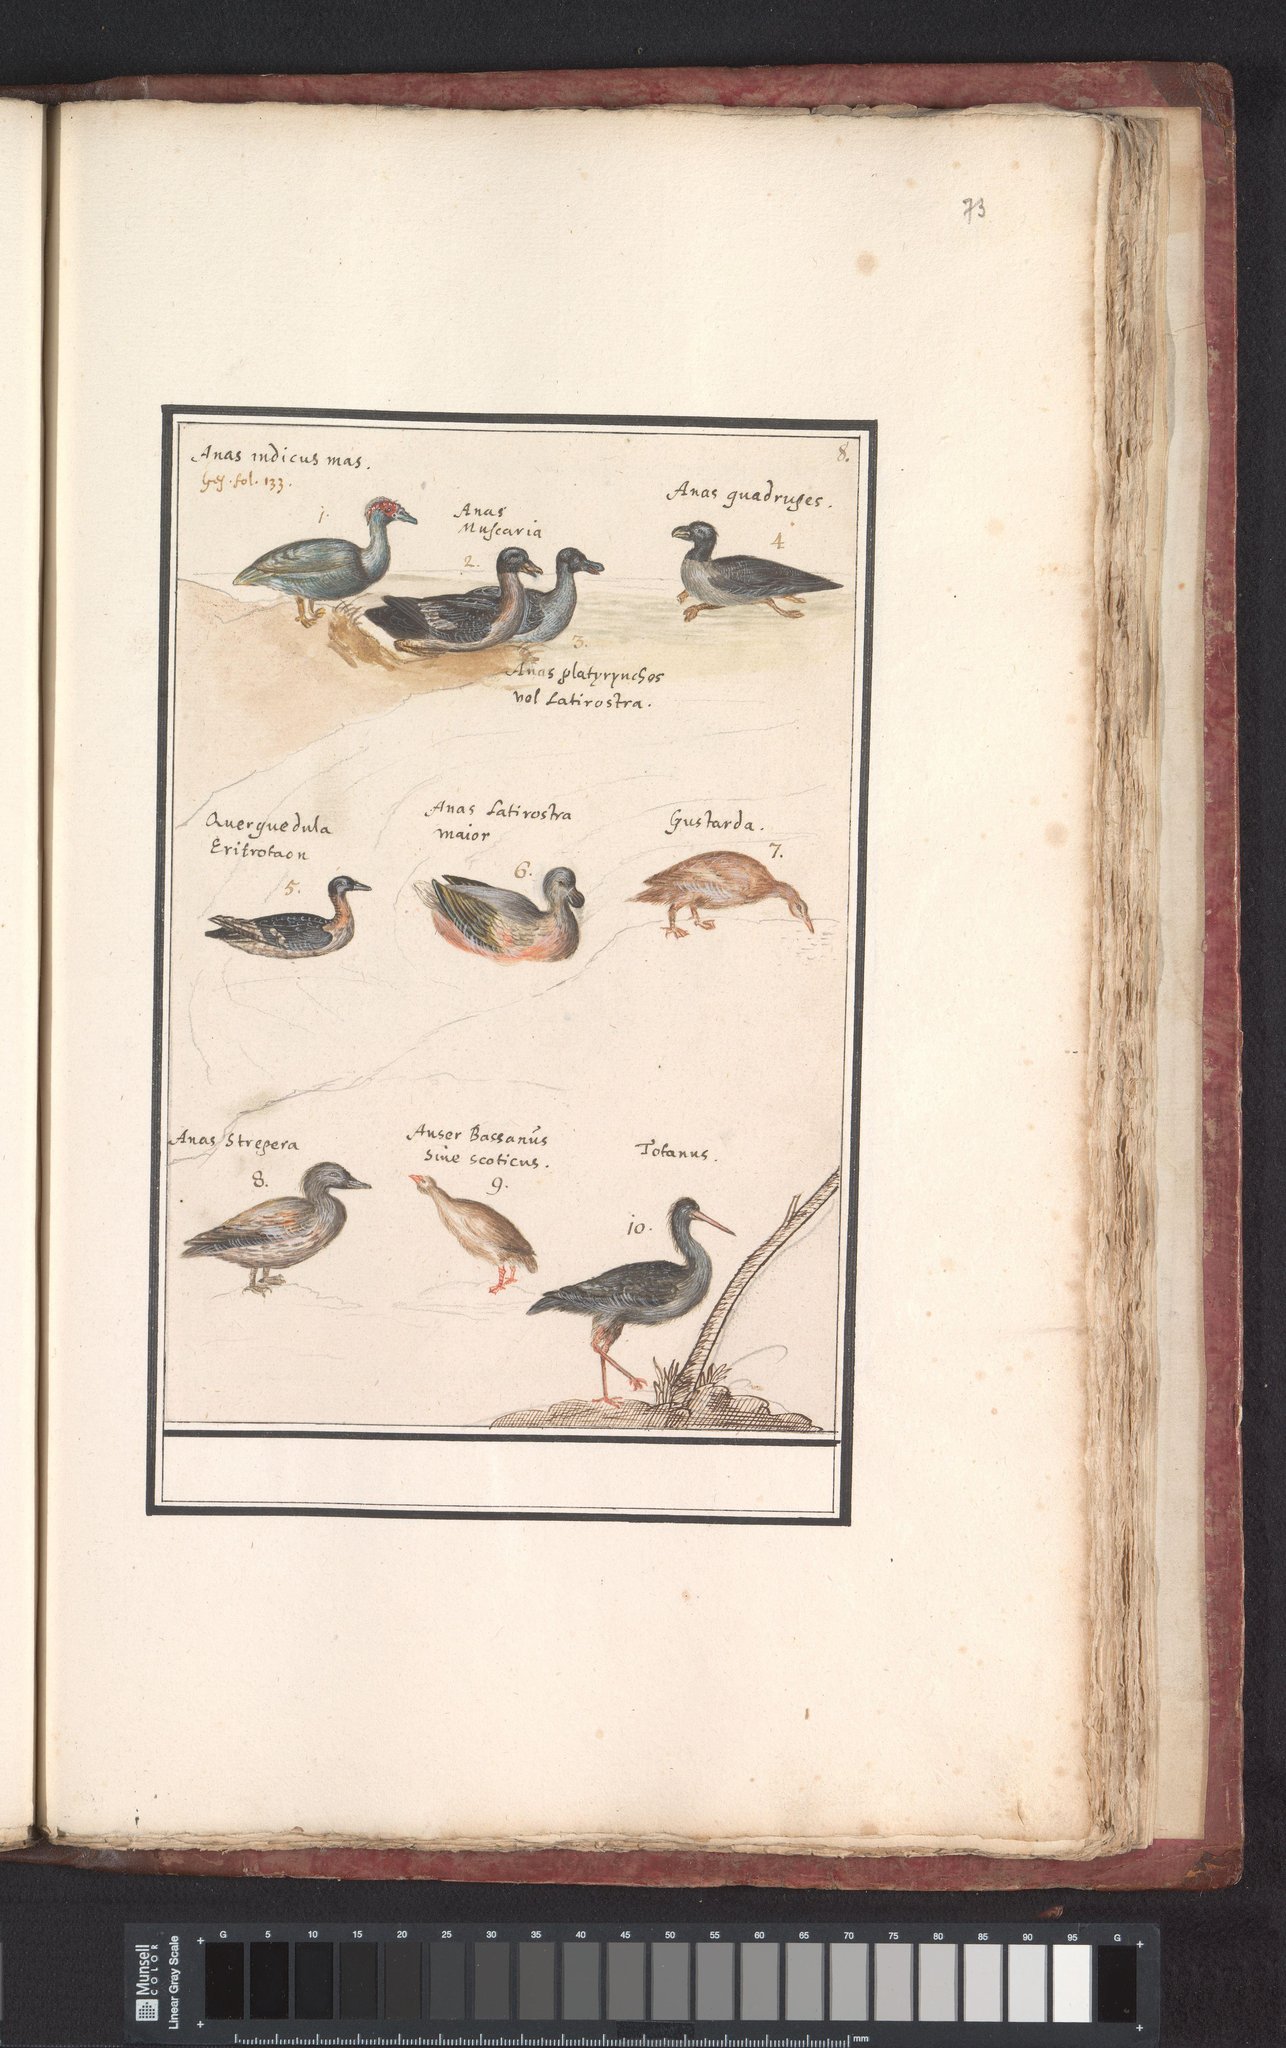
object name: drawing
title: Blad met tien eenden (Anas) en andere watervogels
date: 1596-1610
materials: chalk, paint, ink, paper, pencil, watercolor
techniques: brush, pen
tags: shore-birds and wading-birds: heron, water-birds: northern gannet, water-birds: duck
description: Blad met tien watervogels: verschillende soorten eenden, een jan-van-gent en een reiger. Genummerd rechtsboven: 8. Met de Latijnse namen. Onderdeel van het derde album met tekeningen van vogels. Vijfde van twaalf albums met tekeningen van dieren, vogels en planten bekend rond 1600, gemaakt in opdracht van keizer Rudolf II. Met toelichting in Nederlands, Latijn en Frans.